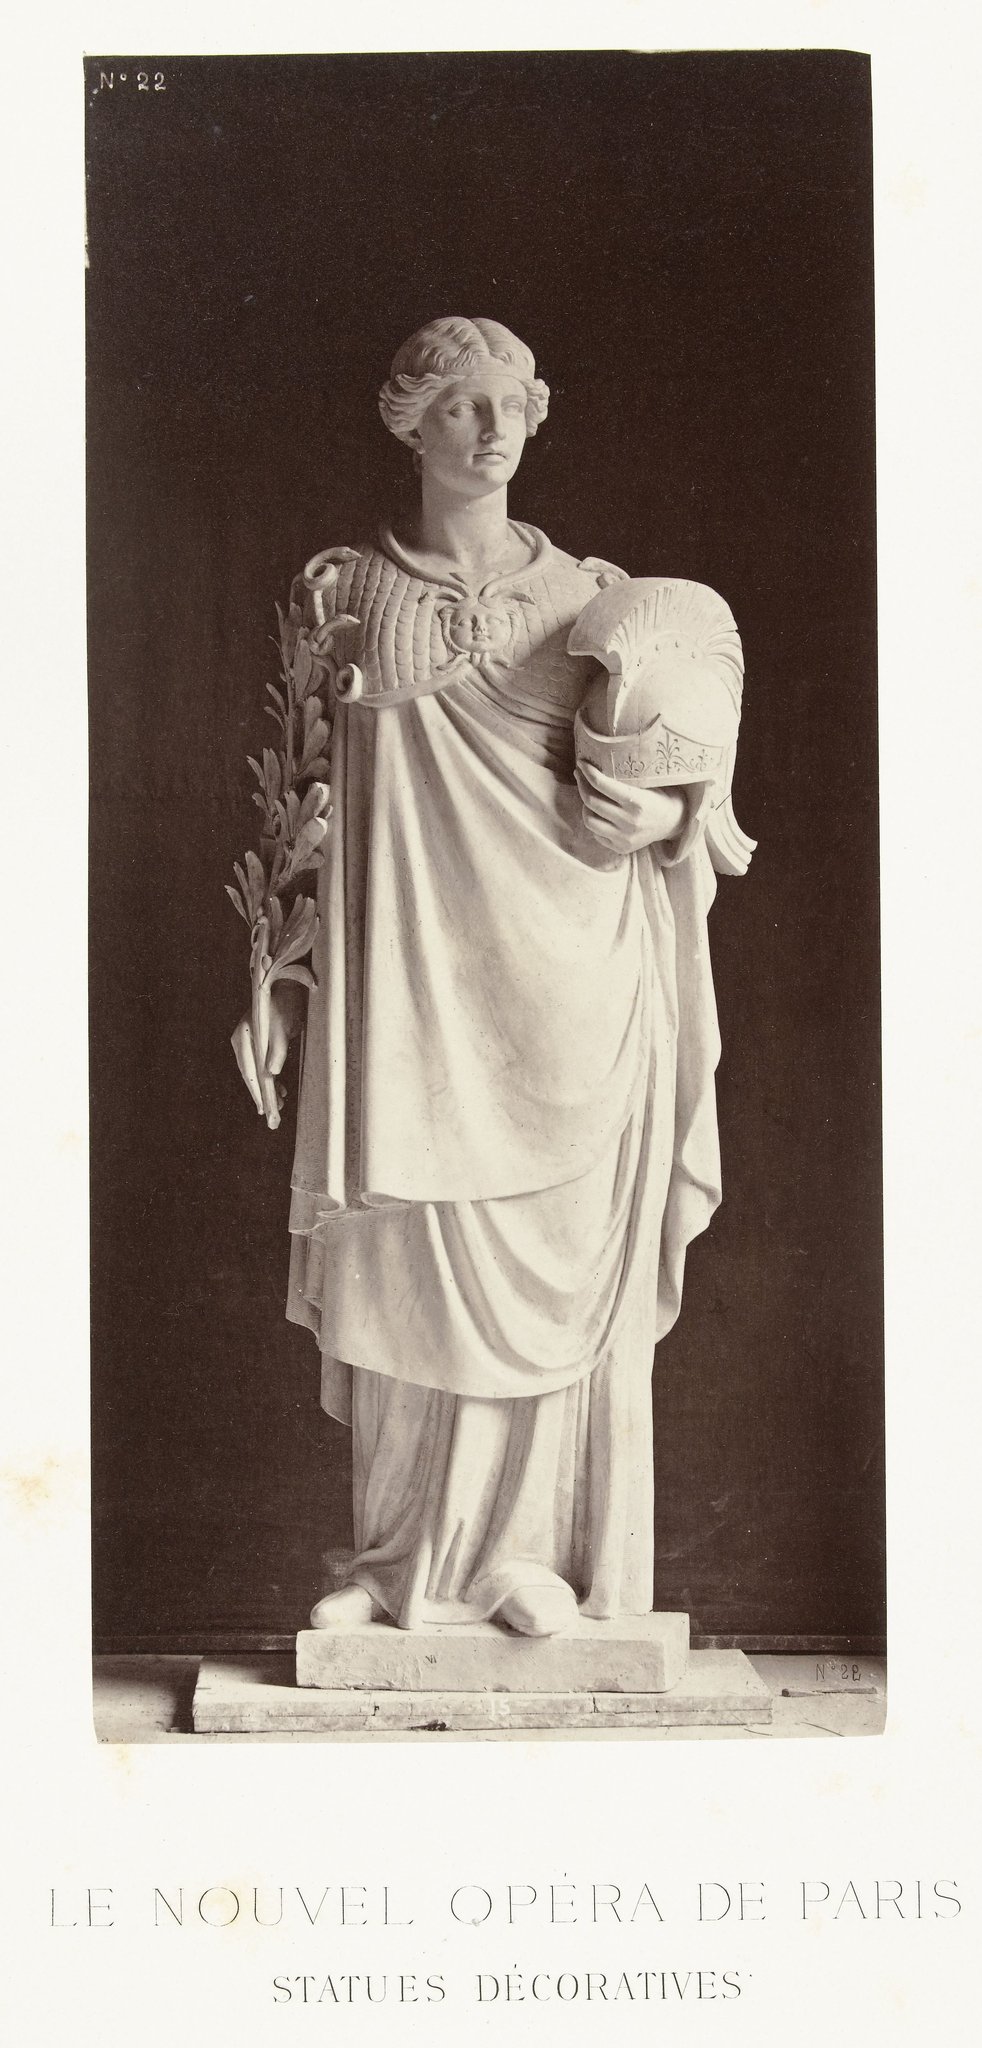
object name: photograph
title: Marmeren beeld van een vrouw gekleed in strijderskostuum met in haar ene hand een helm en de andere een palmtak.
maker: louis-emile durandelle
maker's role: fotograaf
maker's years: 1839-1917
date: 1878-1881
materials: photographic support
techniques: albumen print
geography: paris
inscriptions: number: ‘15’, number: ‘22’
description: bij boek in Bibliotheek RMA, Zie Frizot, pp. 217-223, vgl G. Vicaire, Manuel de l'amateur de livres du XIXe siècle, vol. 3, column 870.